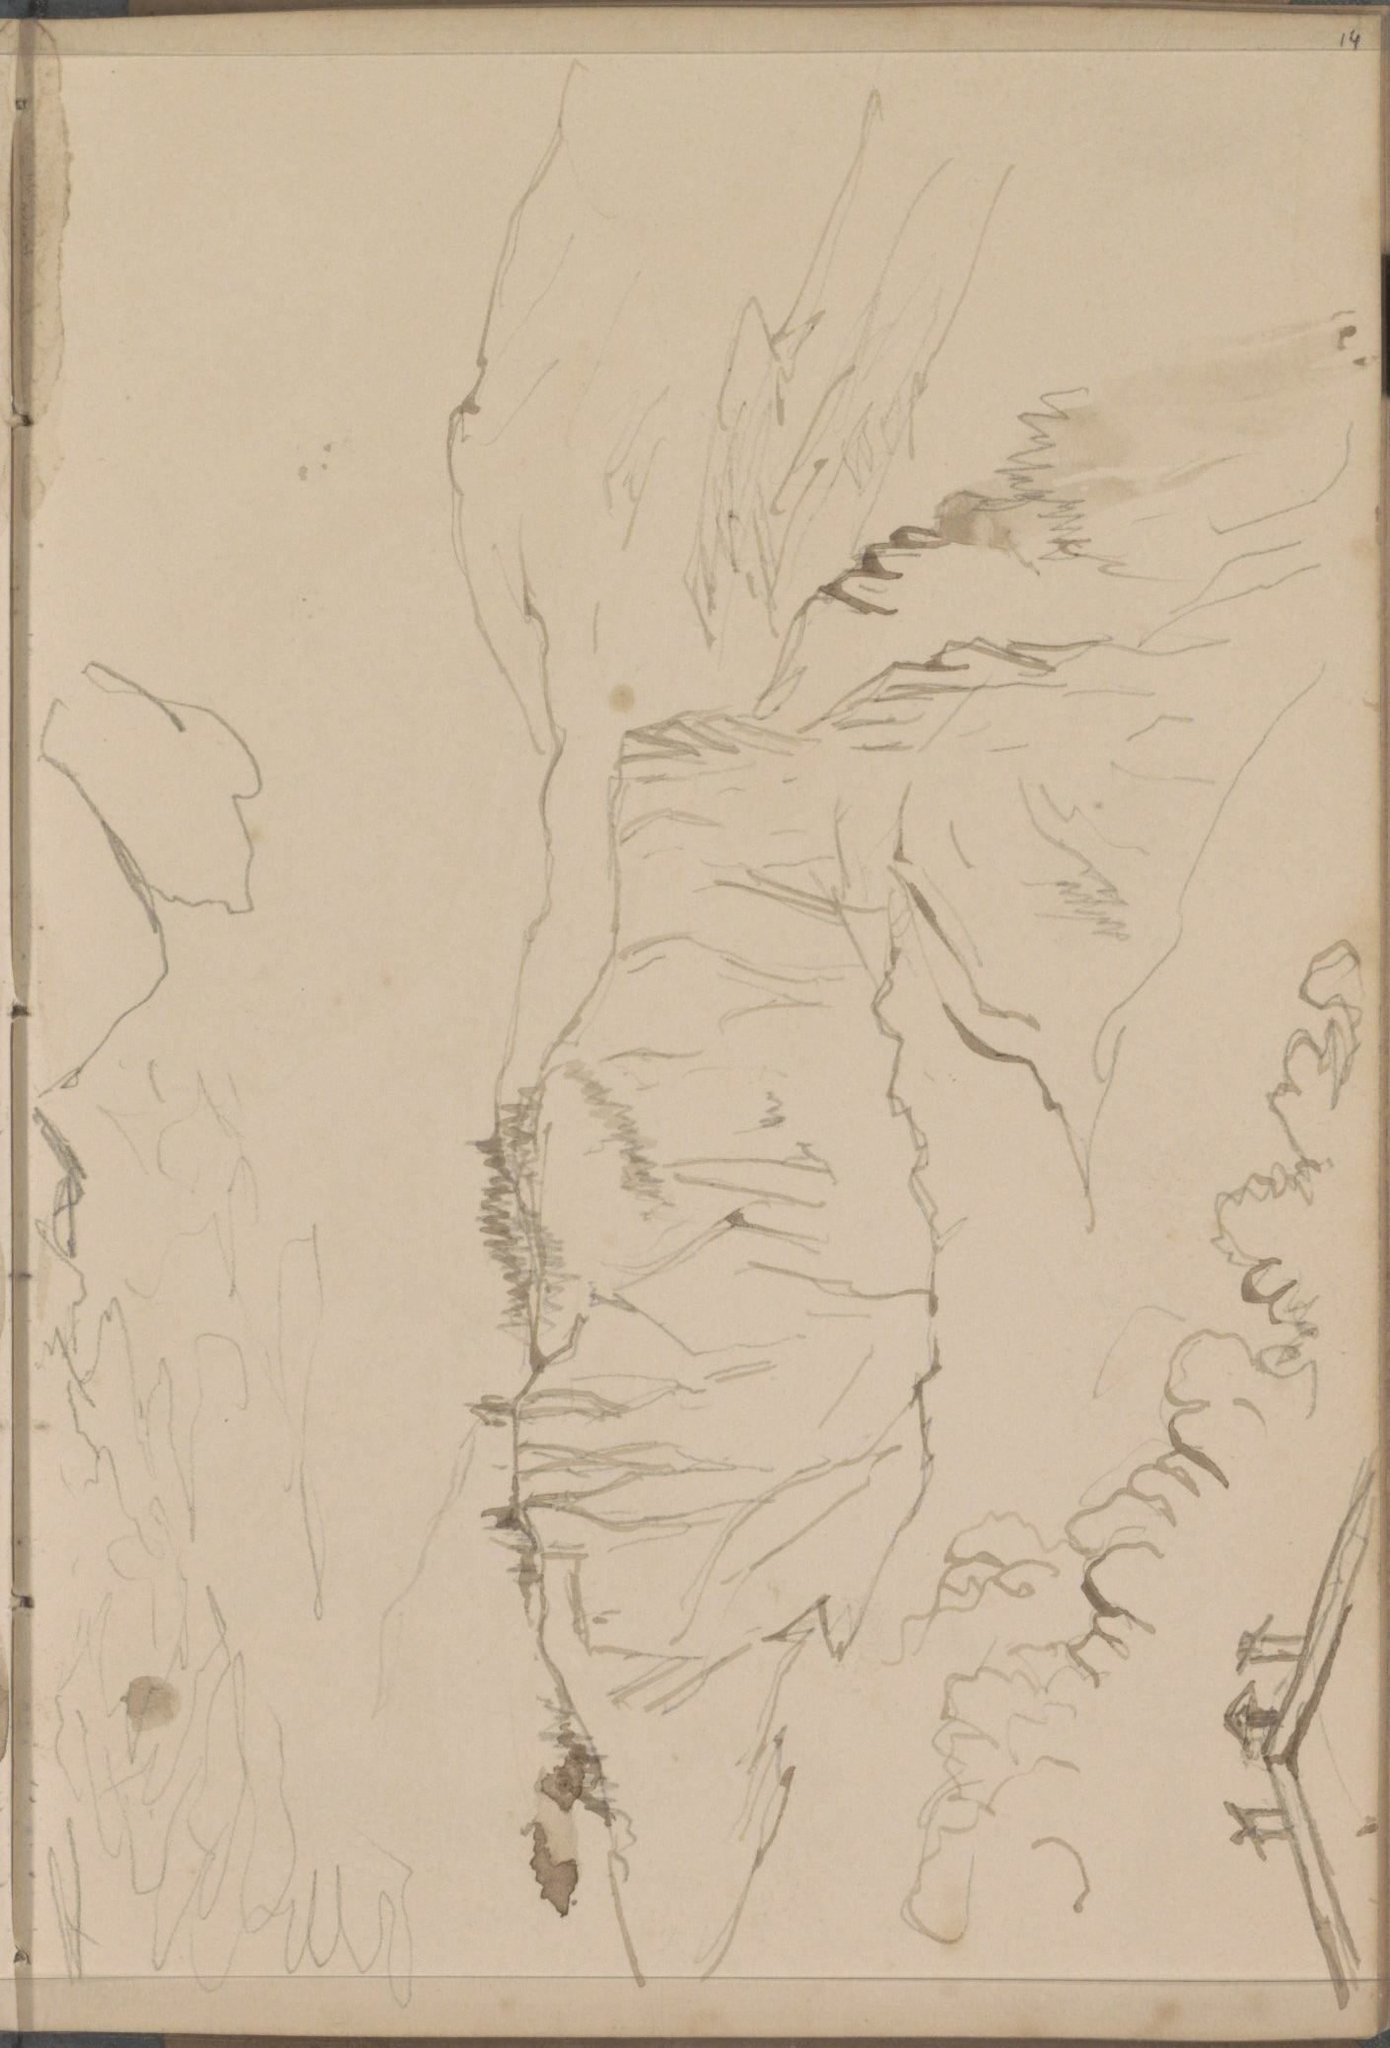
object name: sketchbook leaf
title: Berglandschap met dennenbomen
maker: johannes tavenraat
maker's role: draughtsman, painter, print maker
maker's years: 1809-1881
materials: ink, paper, pencil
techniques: pen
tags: hut, cabin, lodge, trees: pine, mountains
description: Op de voorgrond is een deel van een berghut zichtbaar. Blad 14 recto uit een schetsboek met 47 bladen.